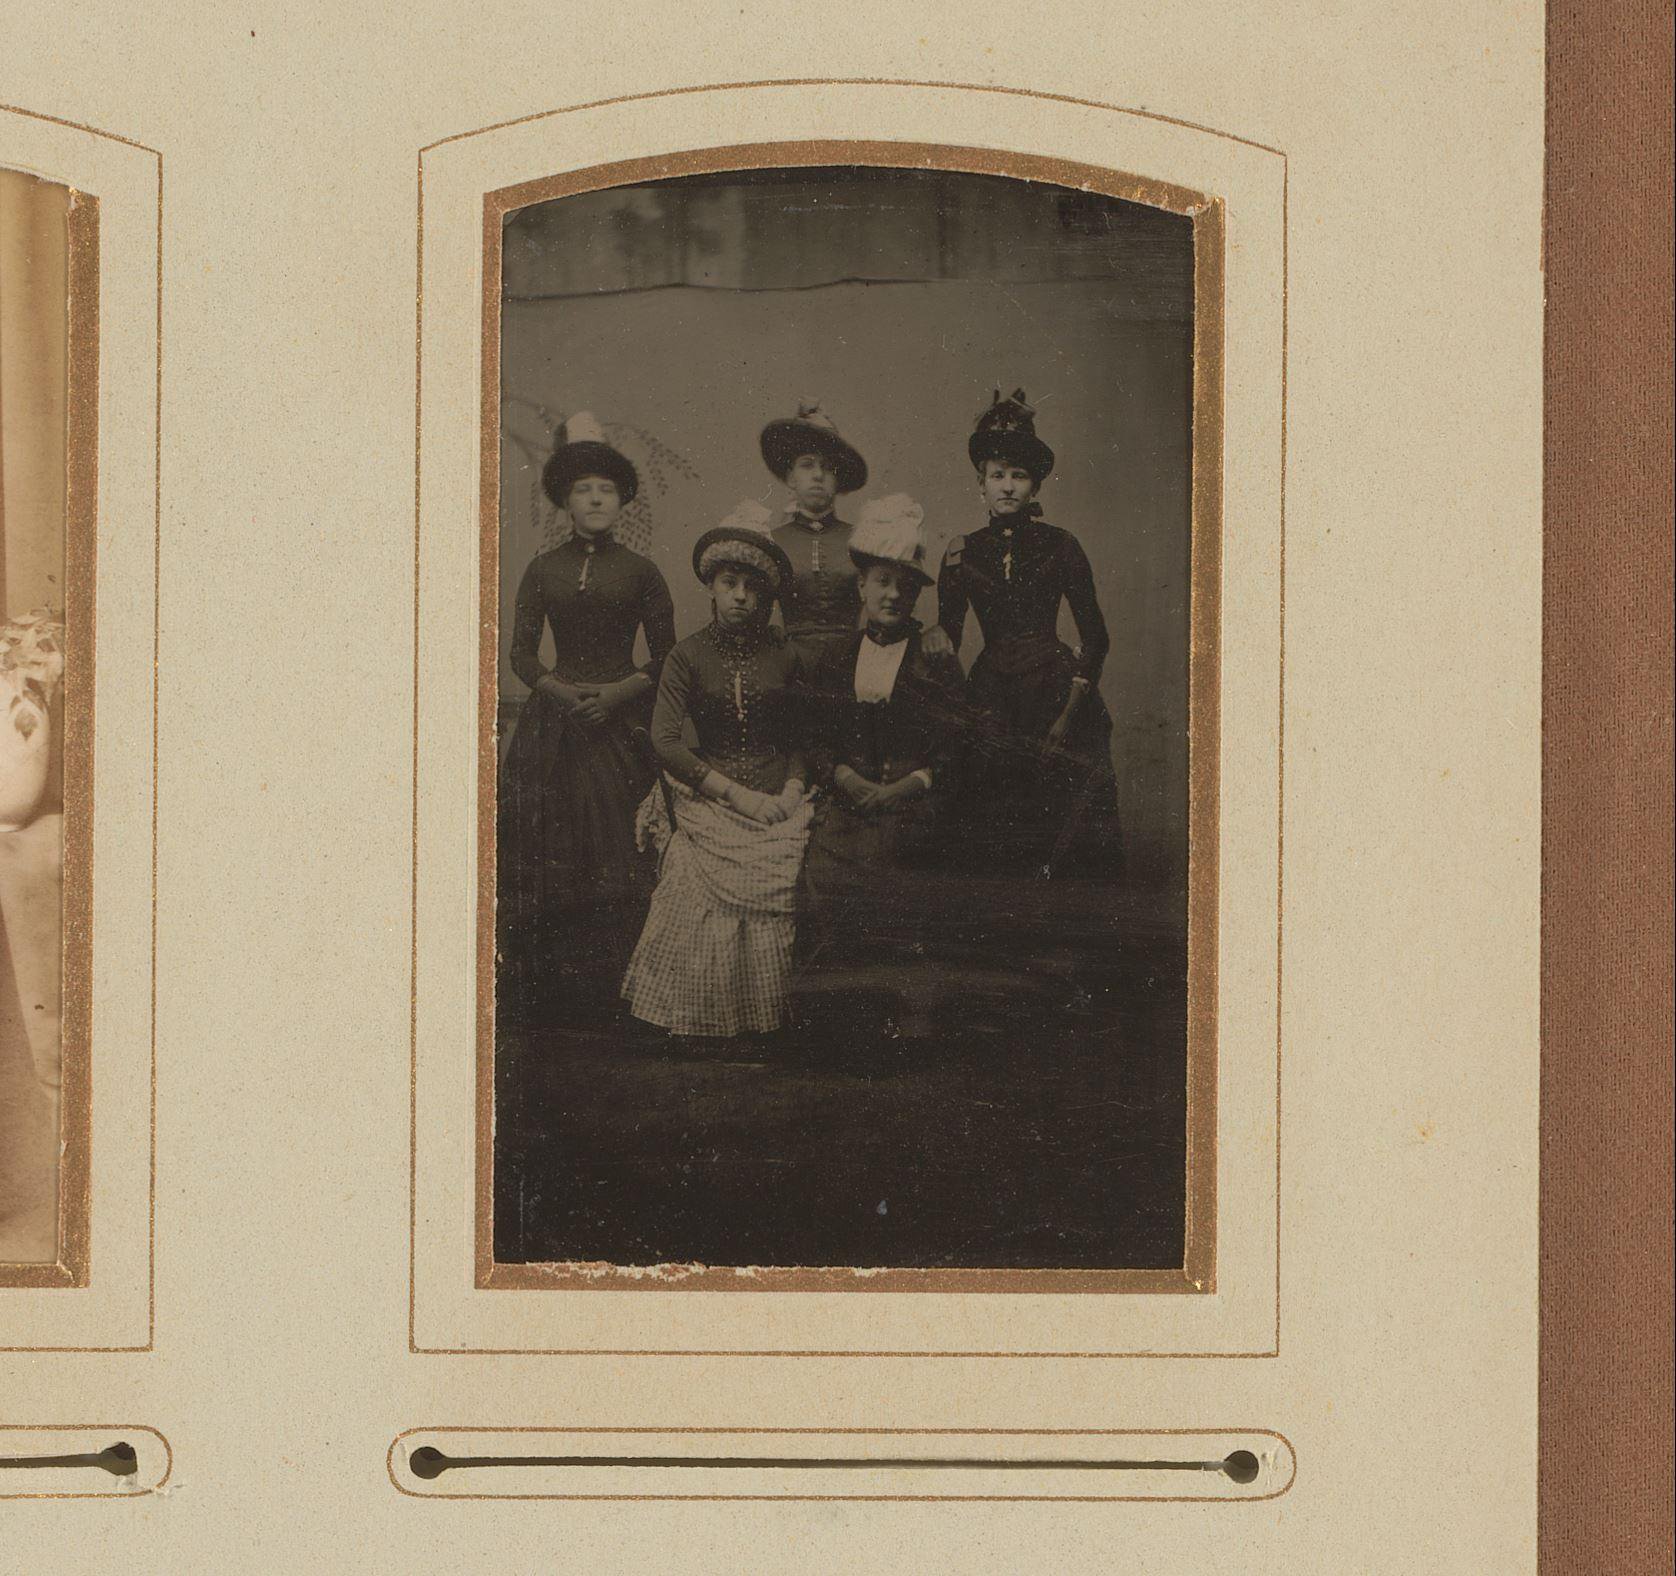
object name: photograph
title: Portret van vijf jonge vrouwen met hoed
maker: Anonymous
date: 1860-1900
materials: metal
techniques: ferrotyping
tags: historical persons - bb - woman, adolescent, young woman, maiden (+ five persons), head-gear: hat